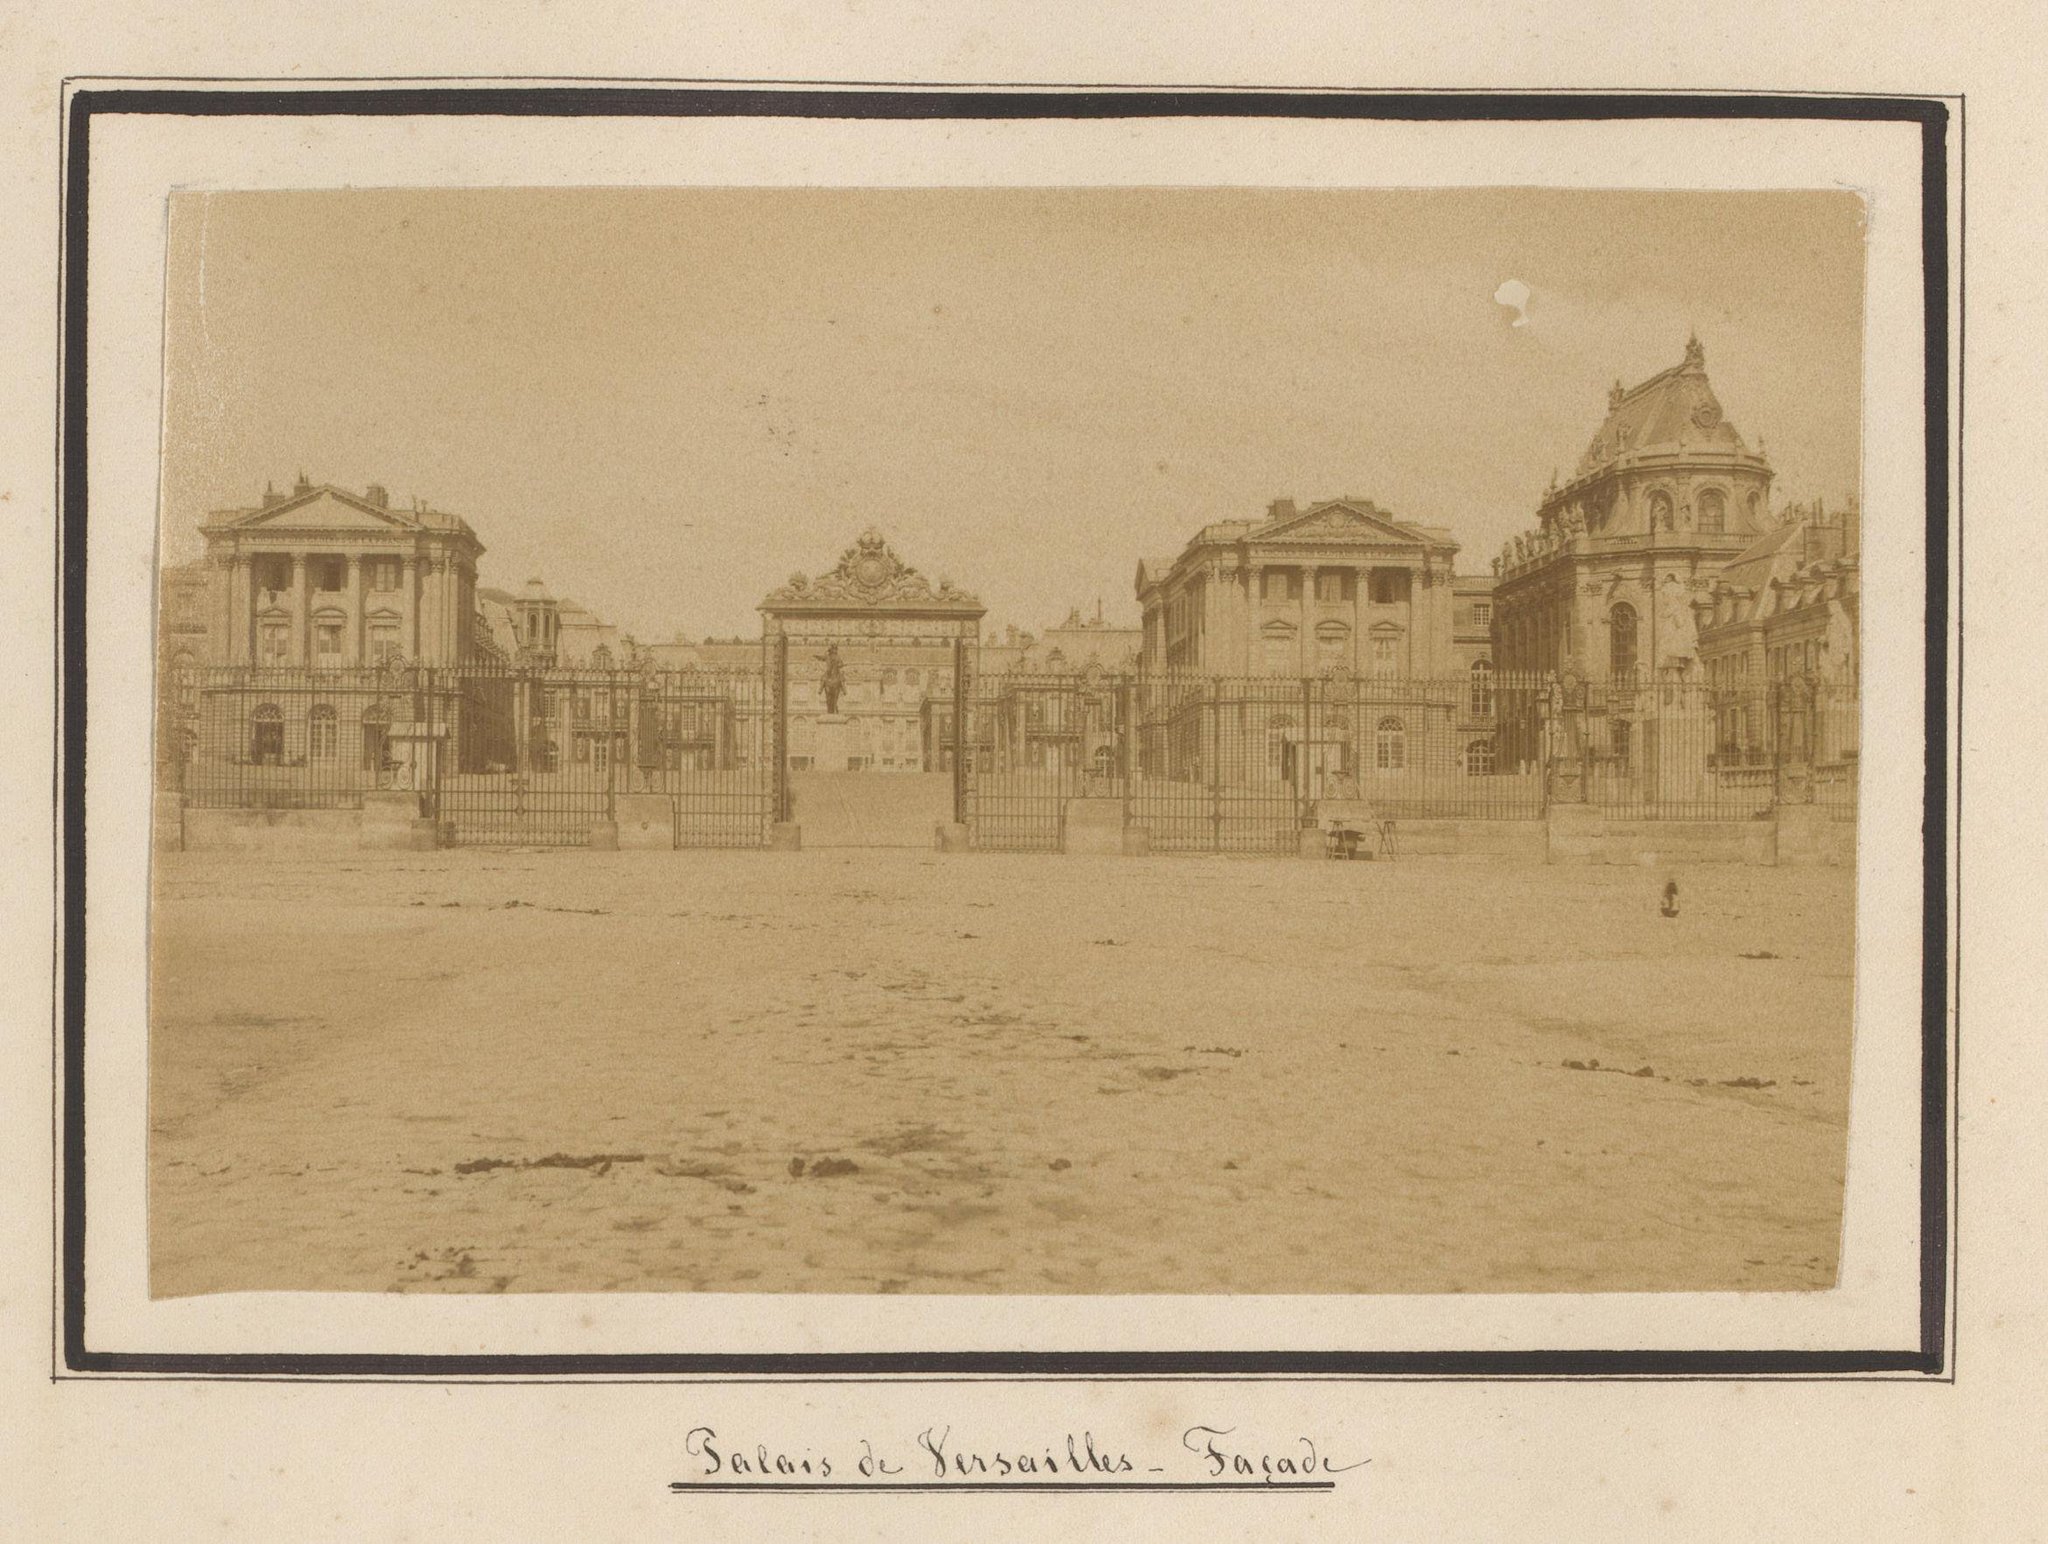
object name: album leaf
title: Palais de Versailles - Façade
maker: Anonymous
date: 1870-1890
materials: paper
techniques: albumen print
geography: versailles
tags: palace